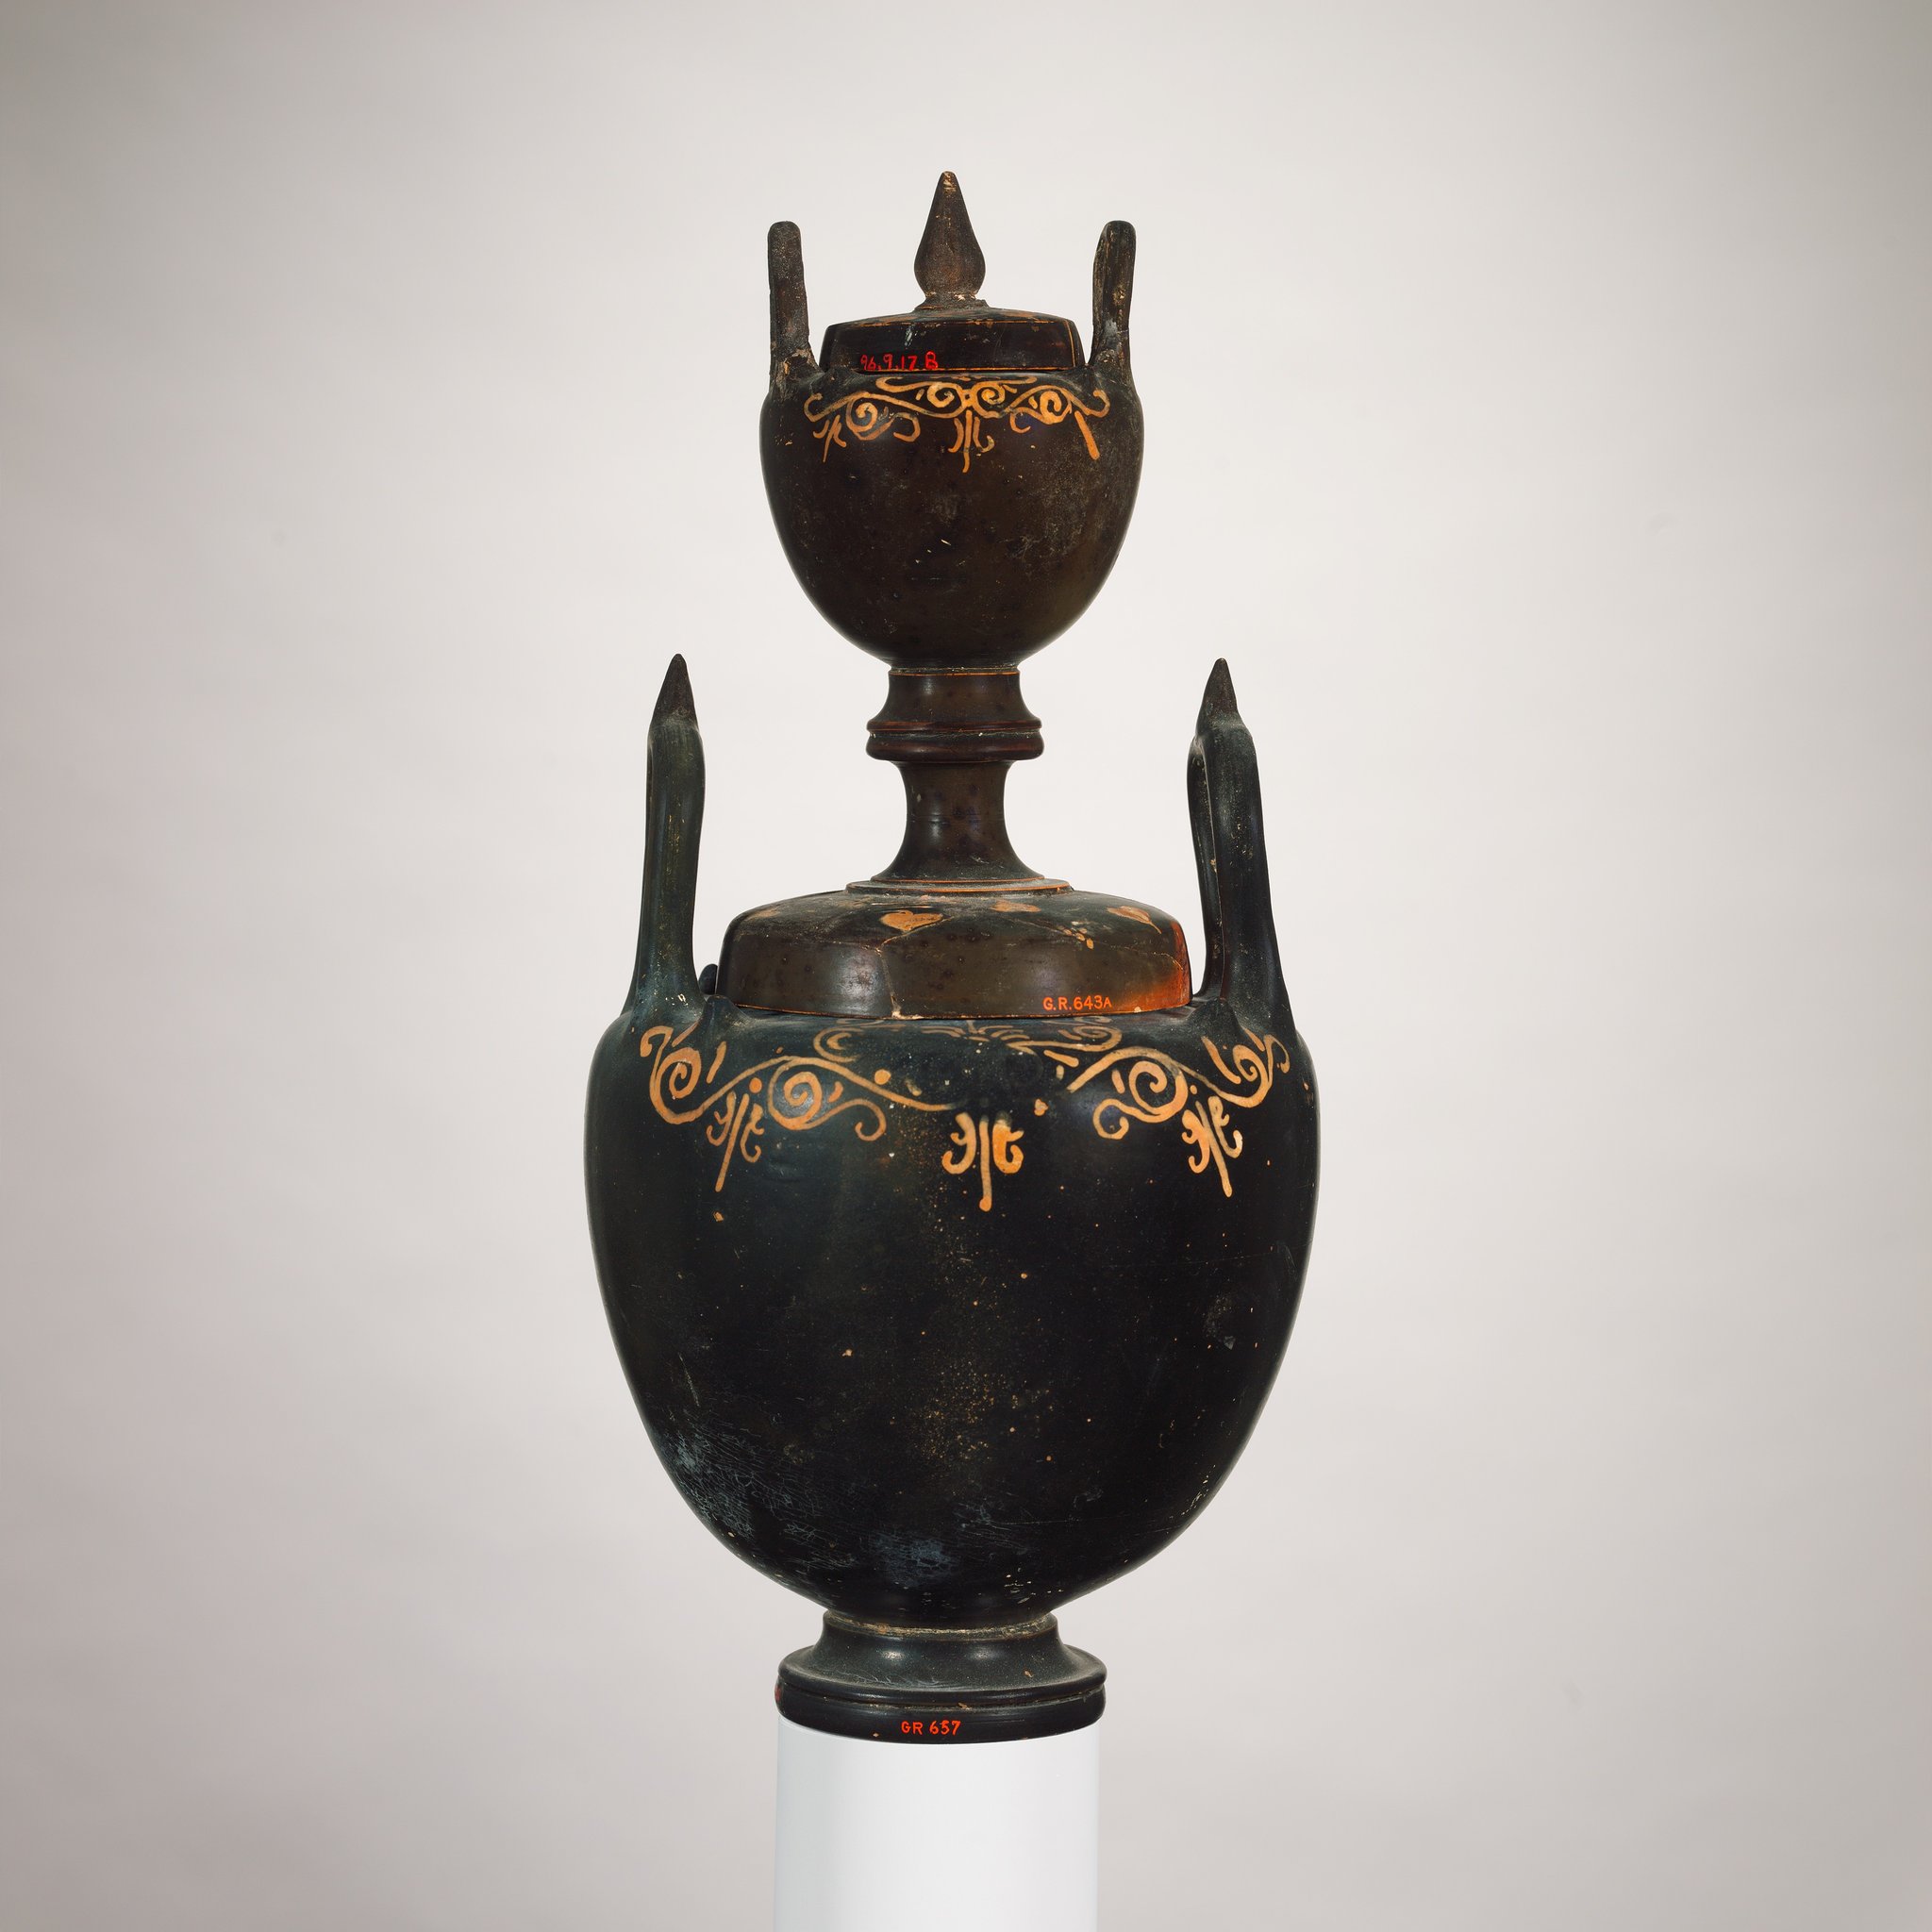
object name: lebes gamikos and lid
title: Terracotta lid of the lebes gamikos 96.9.20 (jar associated with weddings)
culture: greek, south italian, apulian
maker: xenon group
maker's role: artist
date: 400-301 BCE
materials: terracotta